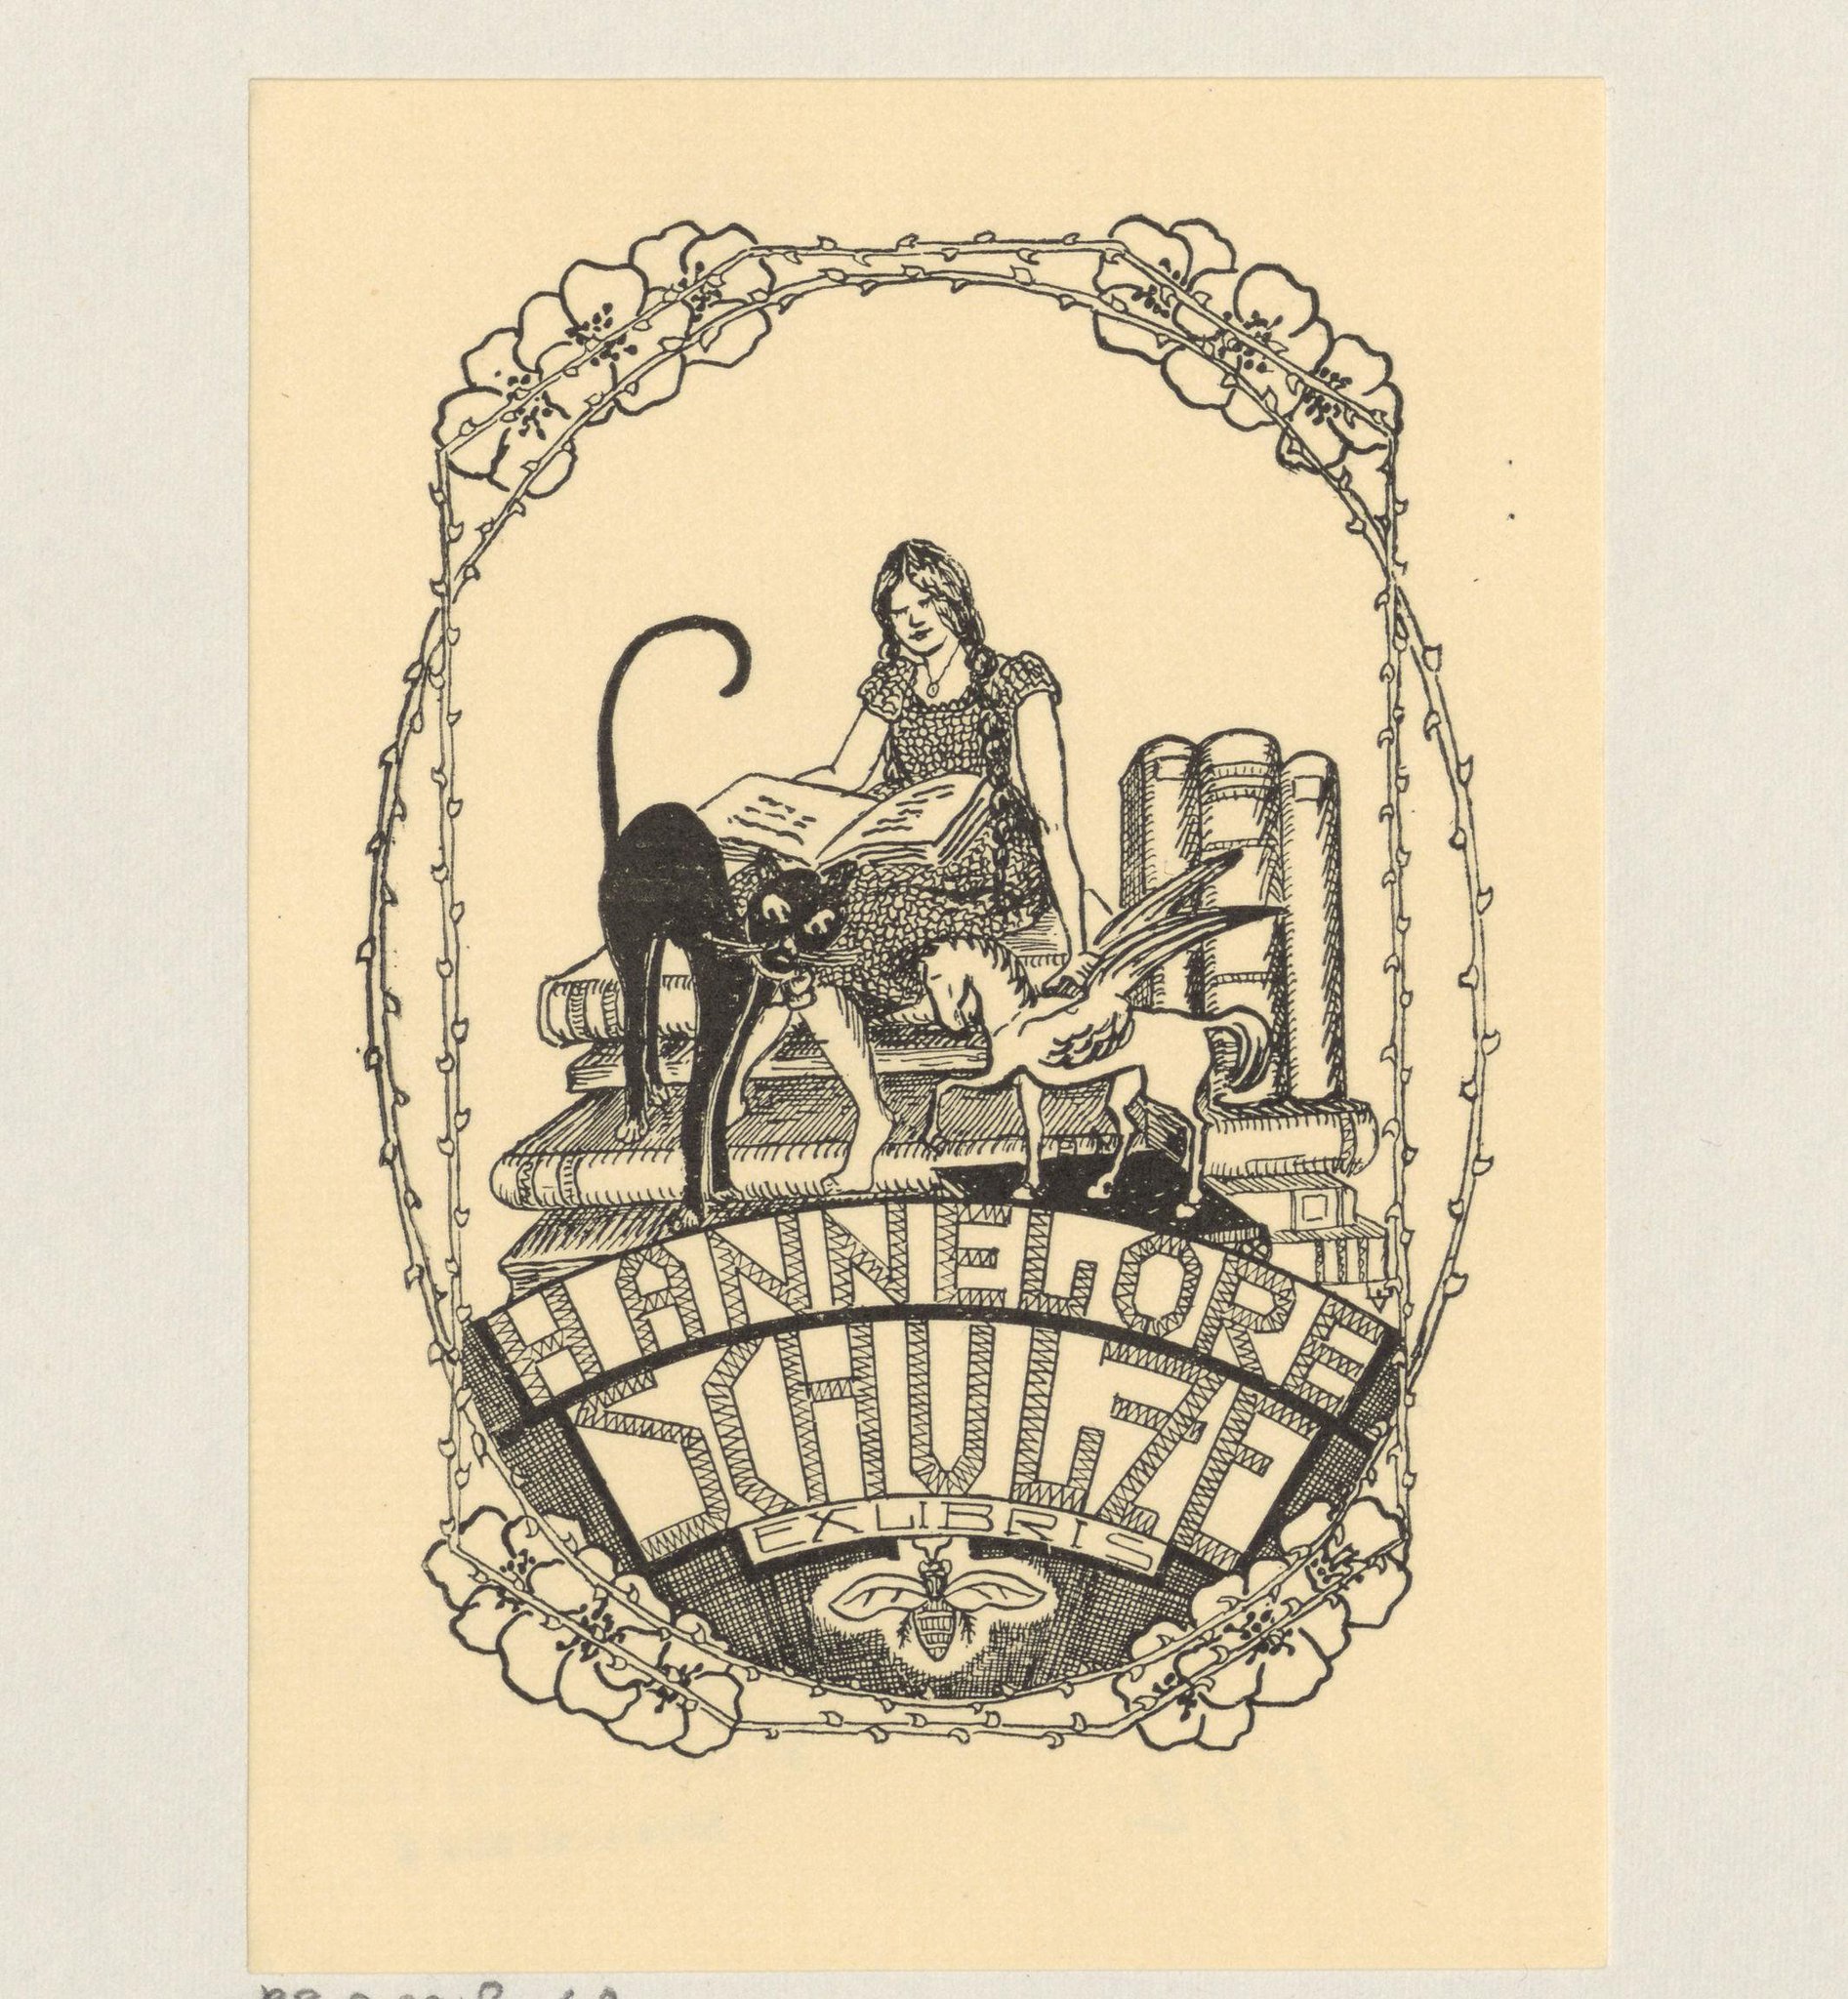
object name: bookplate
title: Ex libris van Hannelore Schulze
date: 1942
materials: paper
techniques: printing block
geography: germany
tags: flowers, adolescent, young woman, maiden, pegasus, the winged horse, reading, cat, book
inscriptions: inscription: ‘Cl. 1942’, workshop stamp: ‘Elisabeth Voges/ Kunstmalerin/ Wolfenbüttel/ Klosterstrasse 2’